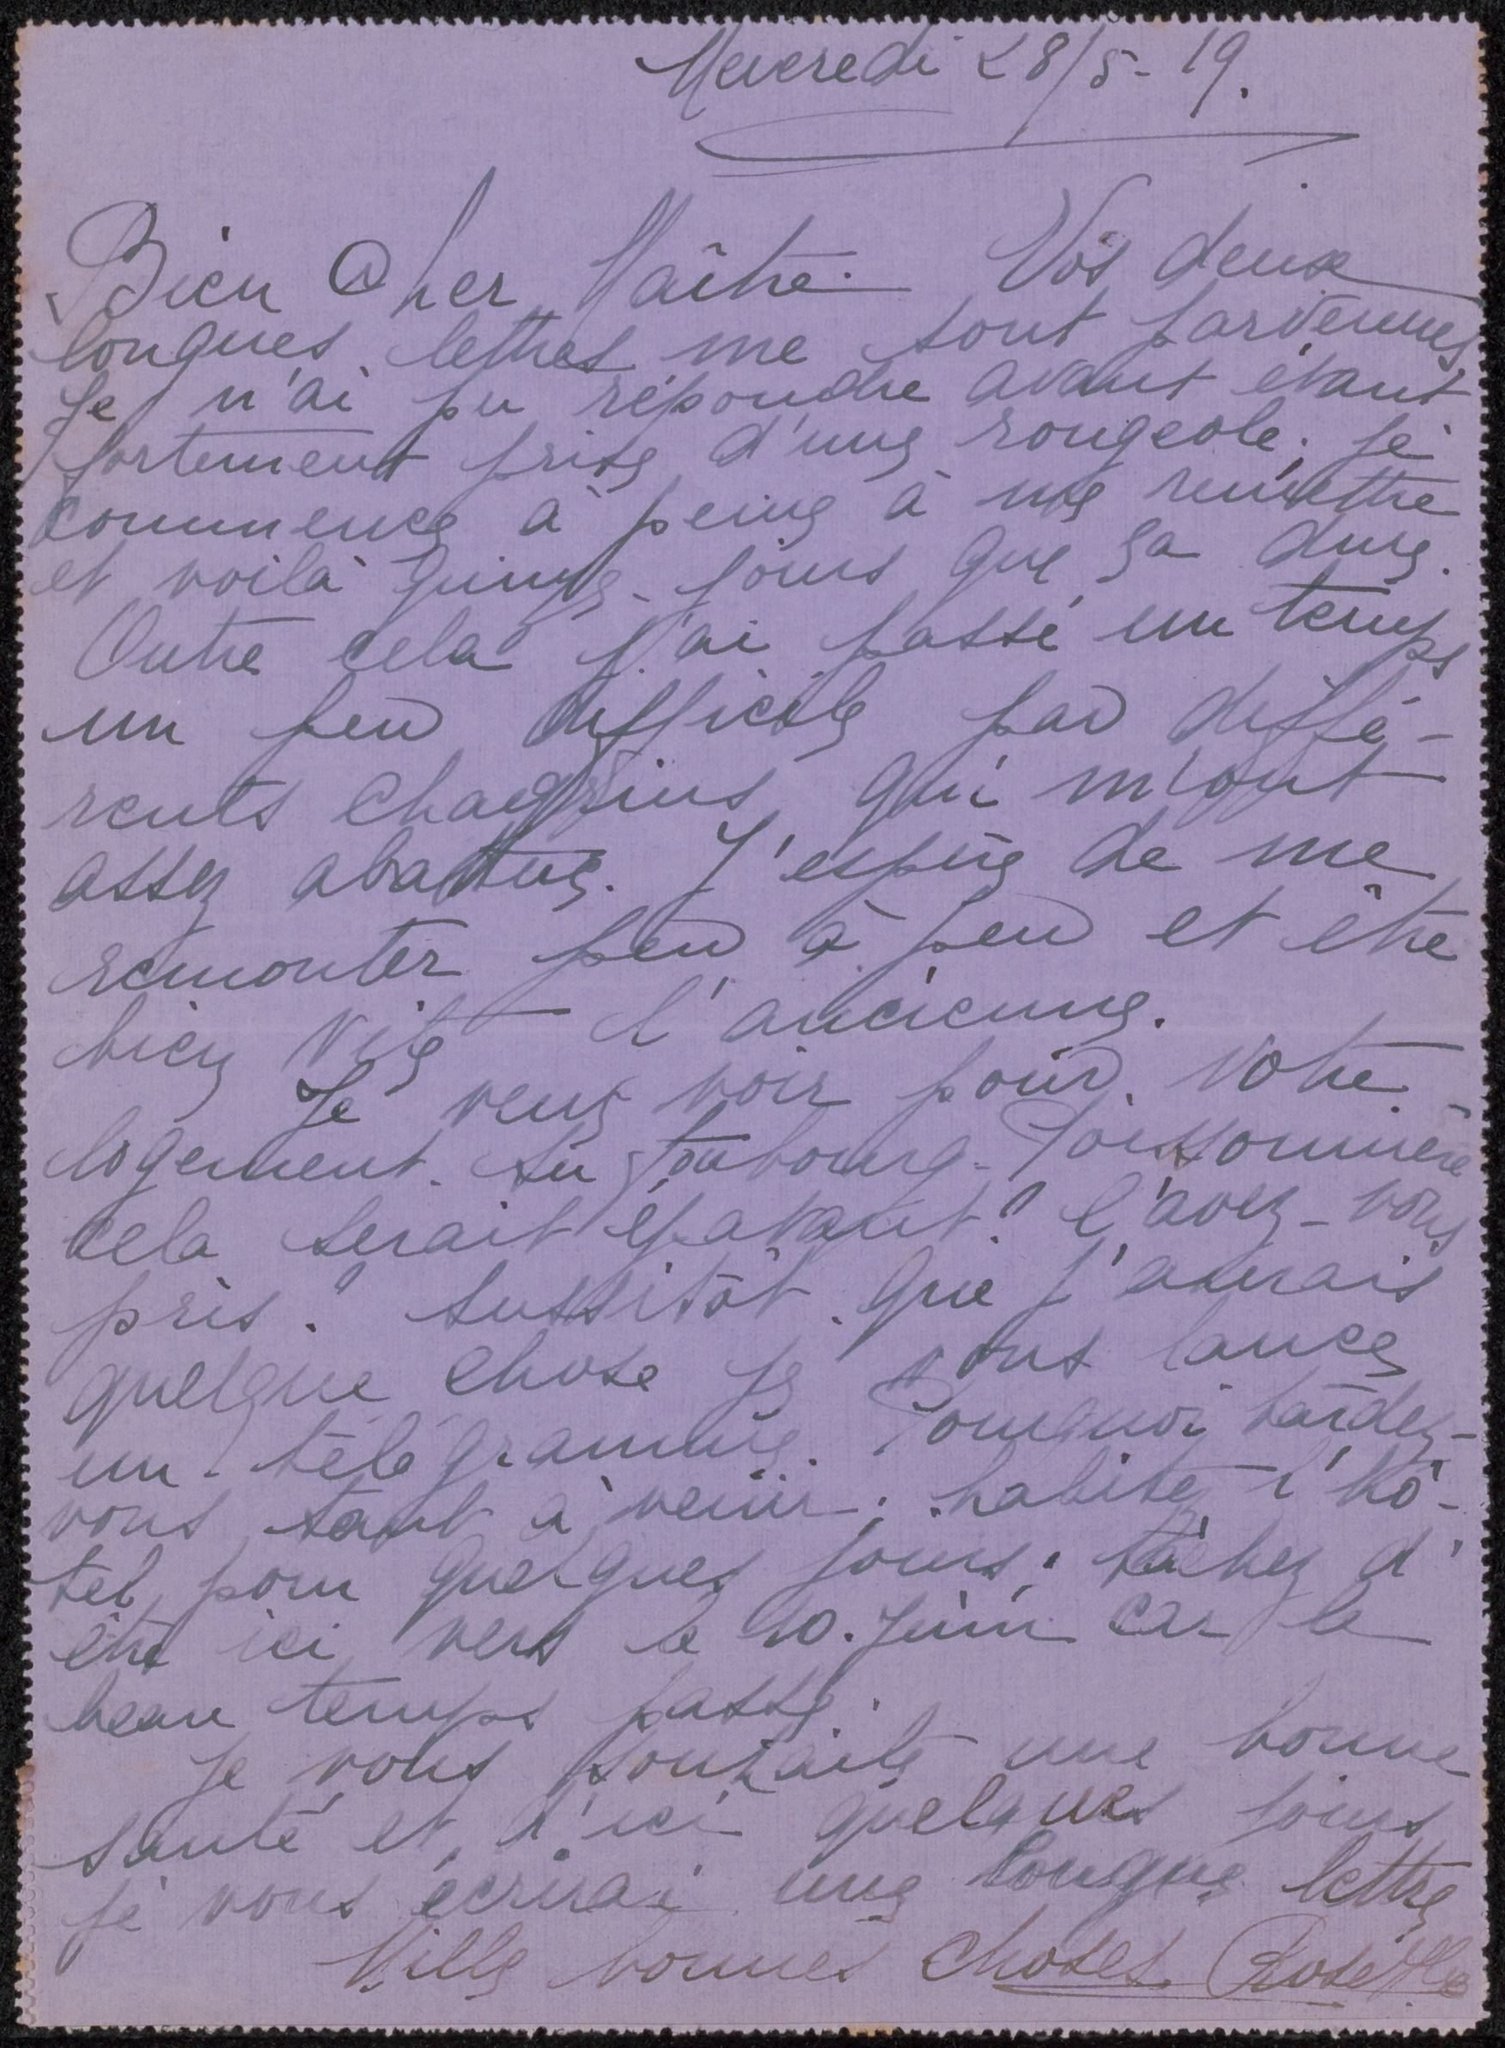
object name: letter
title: Brief aan Philip Zilcken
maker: rose imel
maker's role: draughtsman, painter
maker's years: 1901-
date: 1919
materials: ink, paper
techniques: pen, writing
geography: paris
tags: the hague, philip zilcken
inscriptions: collector's mark: ‘RPK’